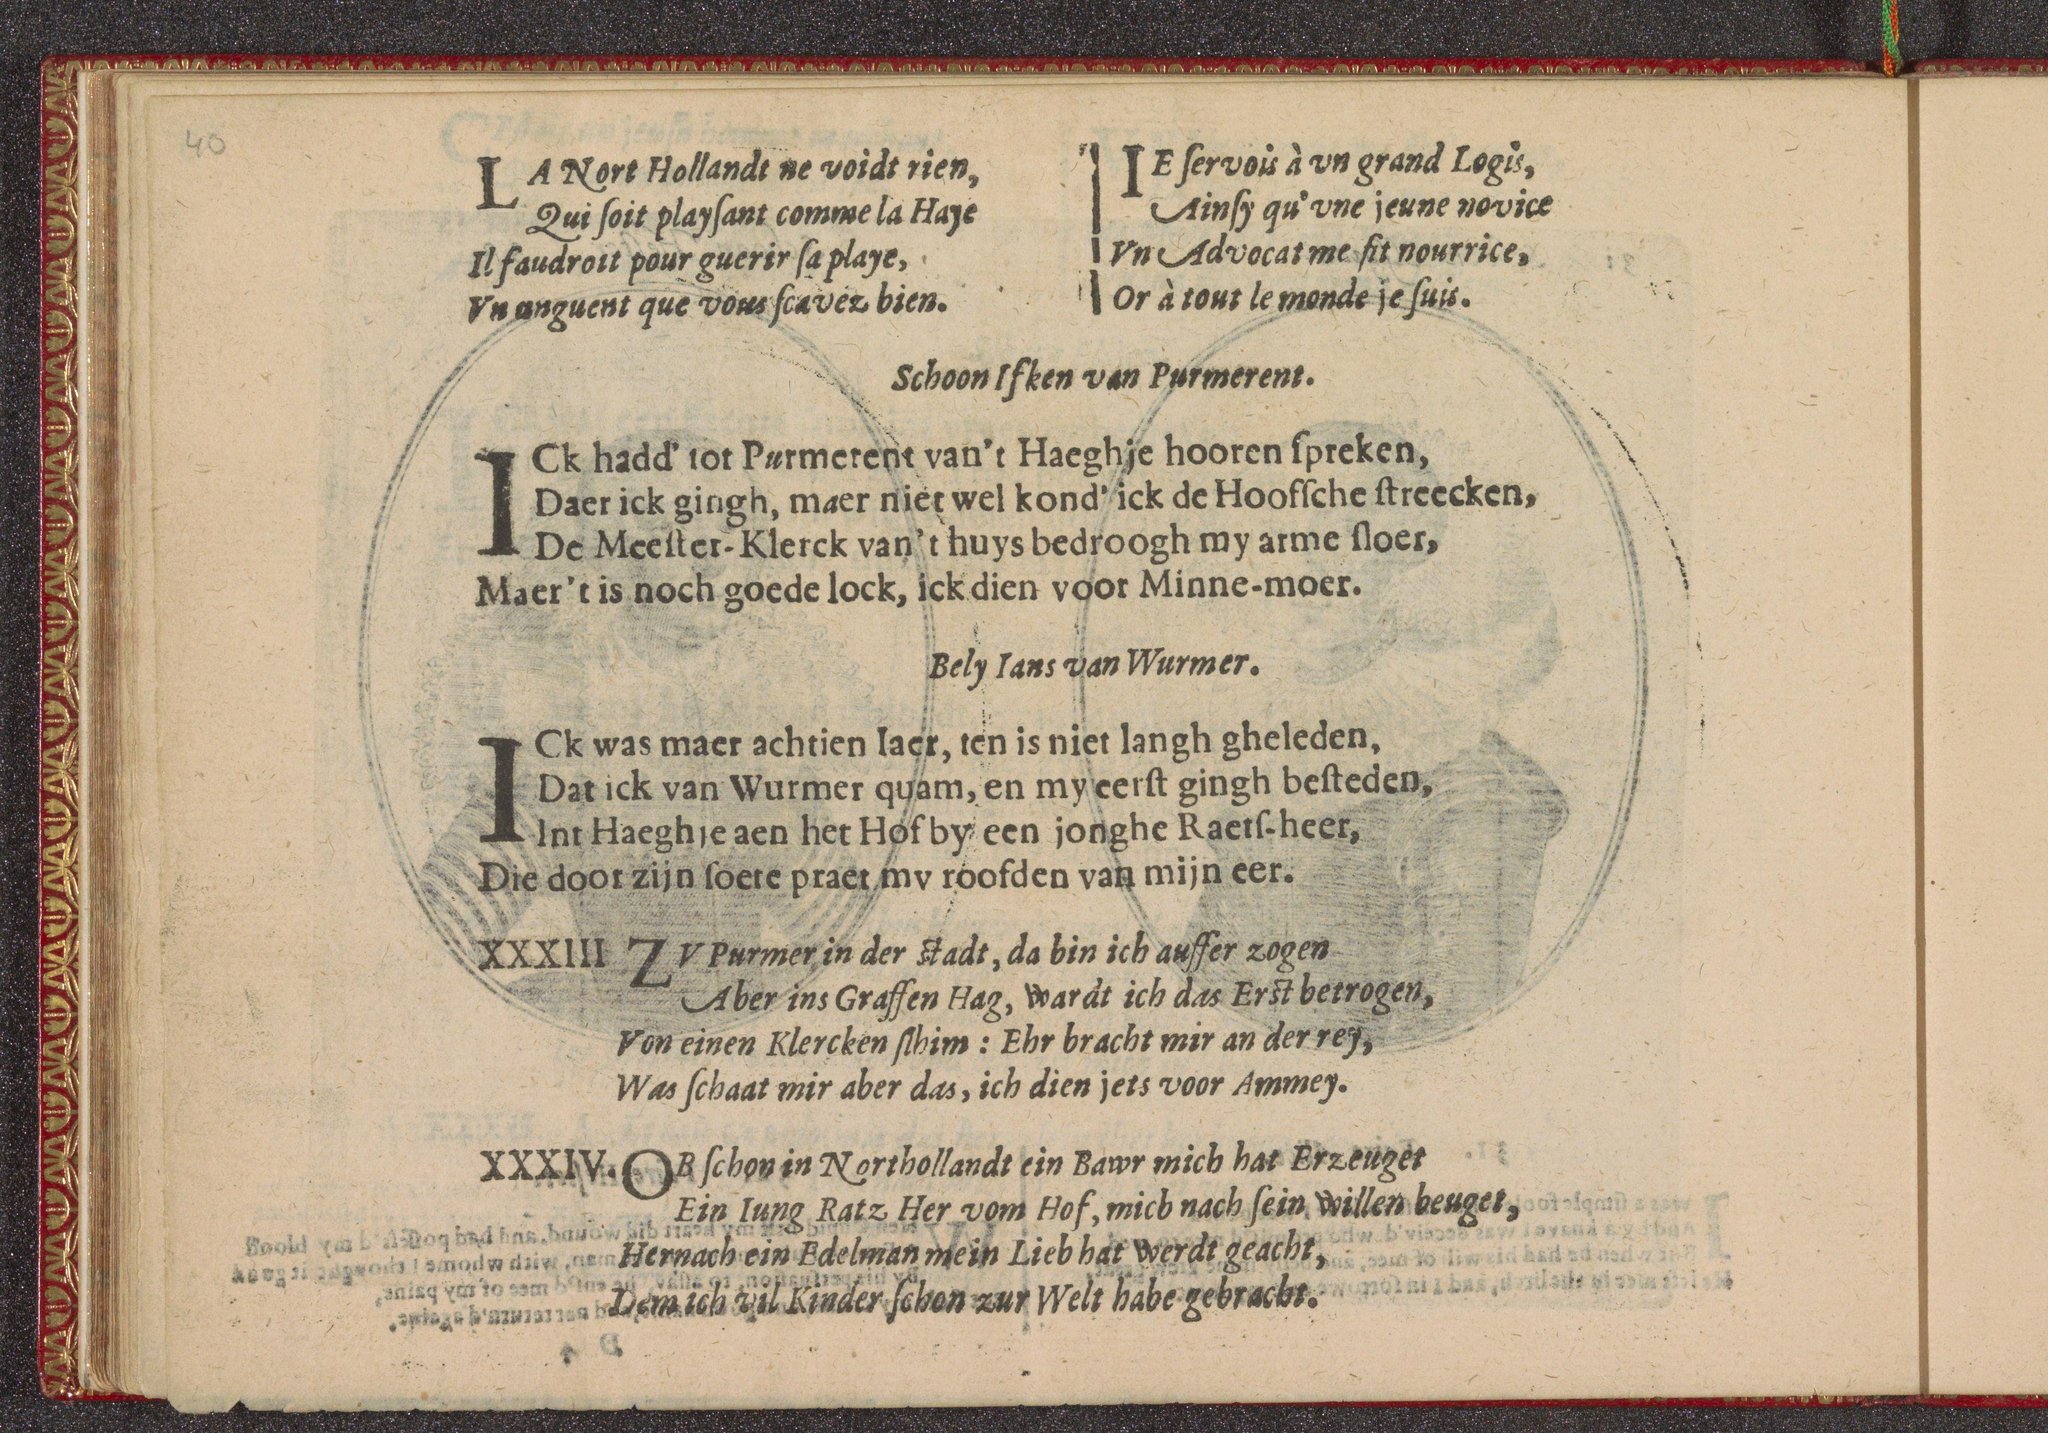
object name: album leaf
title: Miroir des plus belles courtisanes de ce temps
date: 1635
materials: paper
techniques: letterpress printing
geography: utrecht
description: Drie keer twee kwatrijnen in het Frans, Nederlands en Duits bij de portretten van de courtisanes genaamd Schone Ifken van Purmerend en Bes (op dit tekstblad Bely) Jans van Wormer. Het blad maakt deel uit van een album.